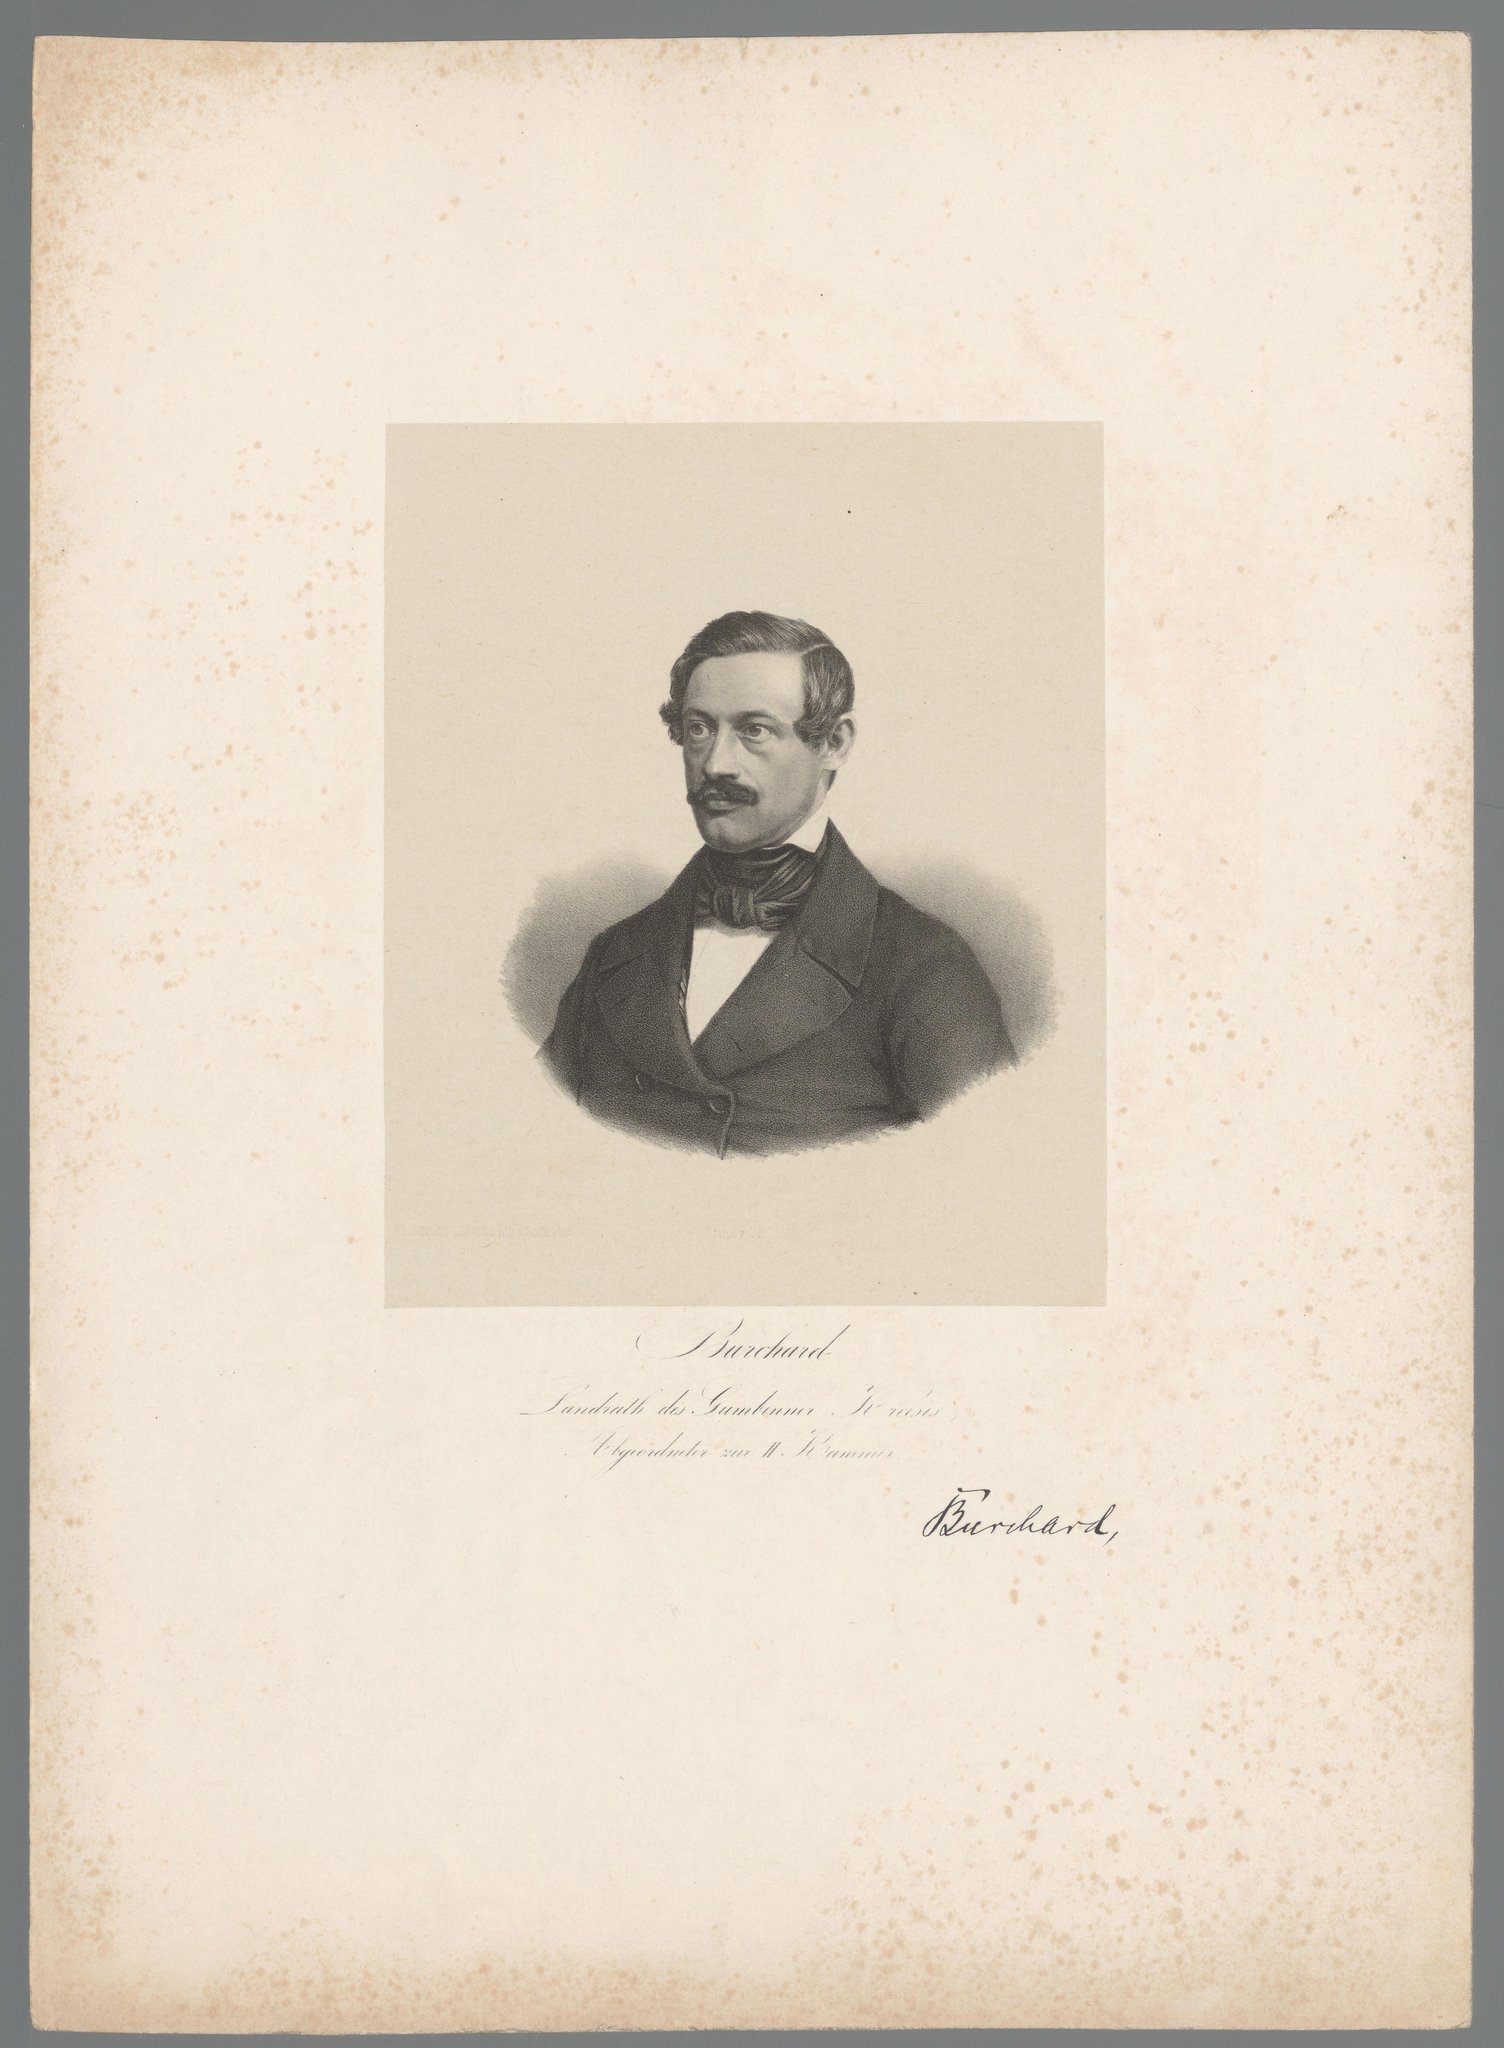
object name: print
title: Portret van Burchard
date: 1830-1860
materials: paper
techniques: lithograph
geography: berlin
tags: moustache, adult man, historical persons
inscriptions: collector's mark: Lugt 2228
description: Prent behoort mogelijk tot de serie 'Expedition des Pantheon', uitgegeven door Albert Sacco.